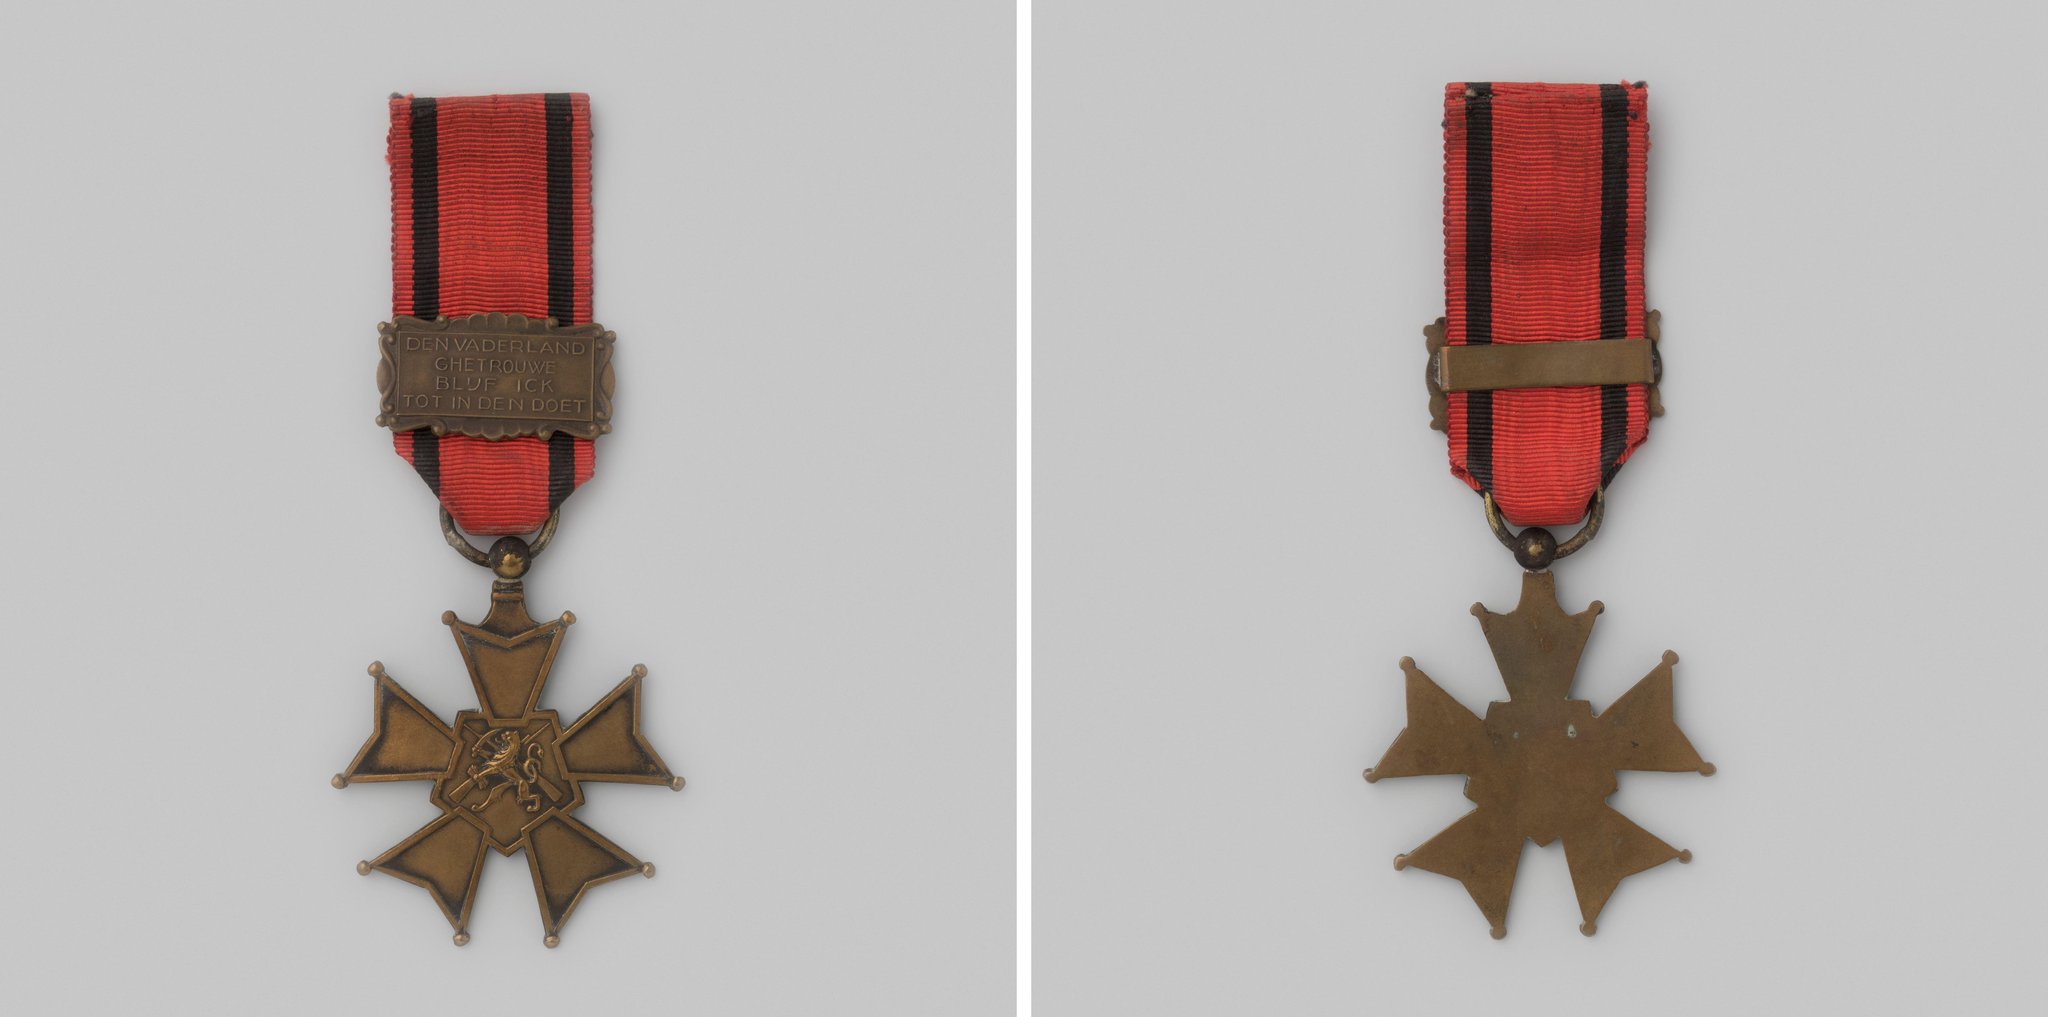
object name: draagpenning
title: Draagpenning van een vijfarmig metalen kruis waarop de Nederlandse leeuw met twee geweren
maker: Anonymous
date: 1820-1949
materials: metal, textile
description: Metalen vijfarmig kruis met knop, ring en lint. Aan het lint een metalen band met opschrift: DEN VADERLAND / GHETROUWE / BLIJF ICK / TOT IN DEN DOET. In het midden van het kruis een naar links gewende leeuw met in zijn klauwen twee geweren.